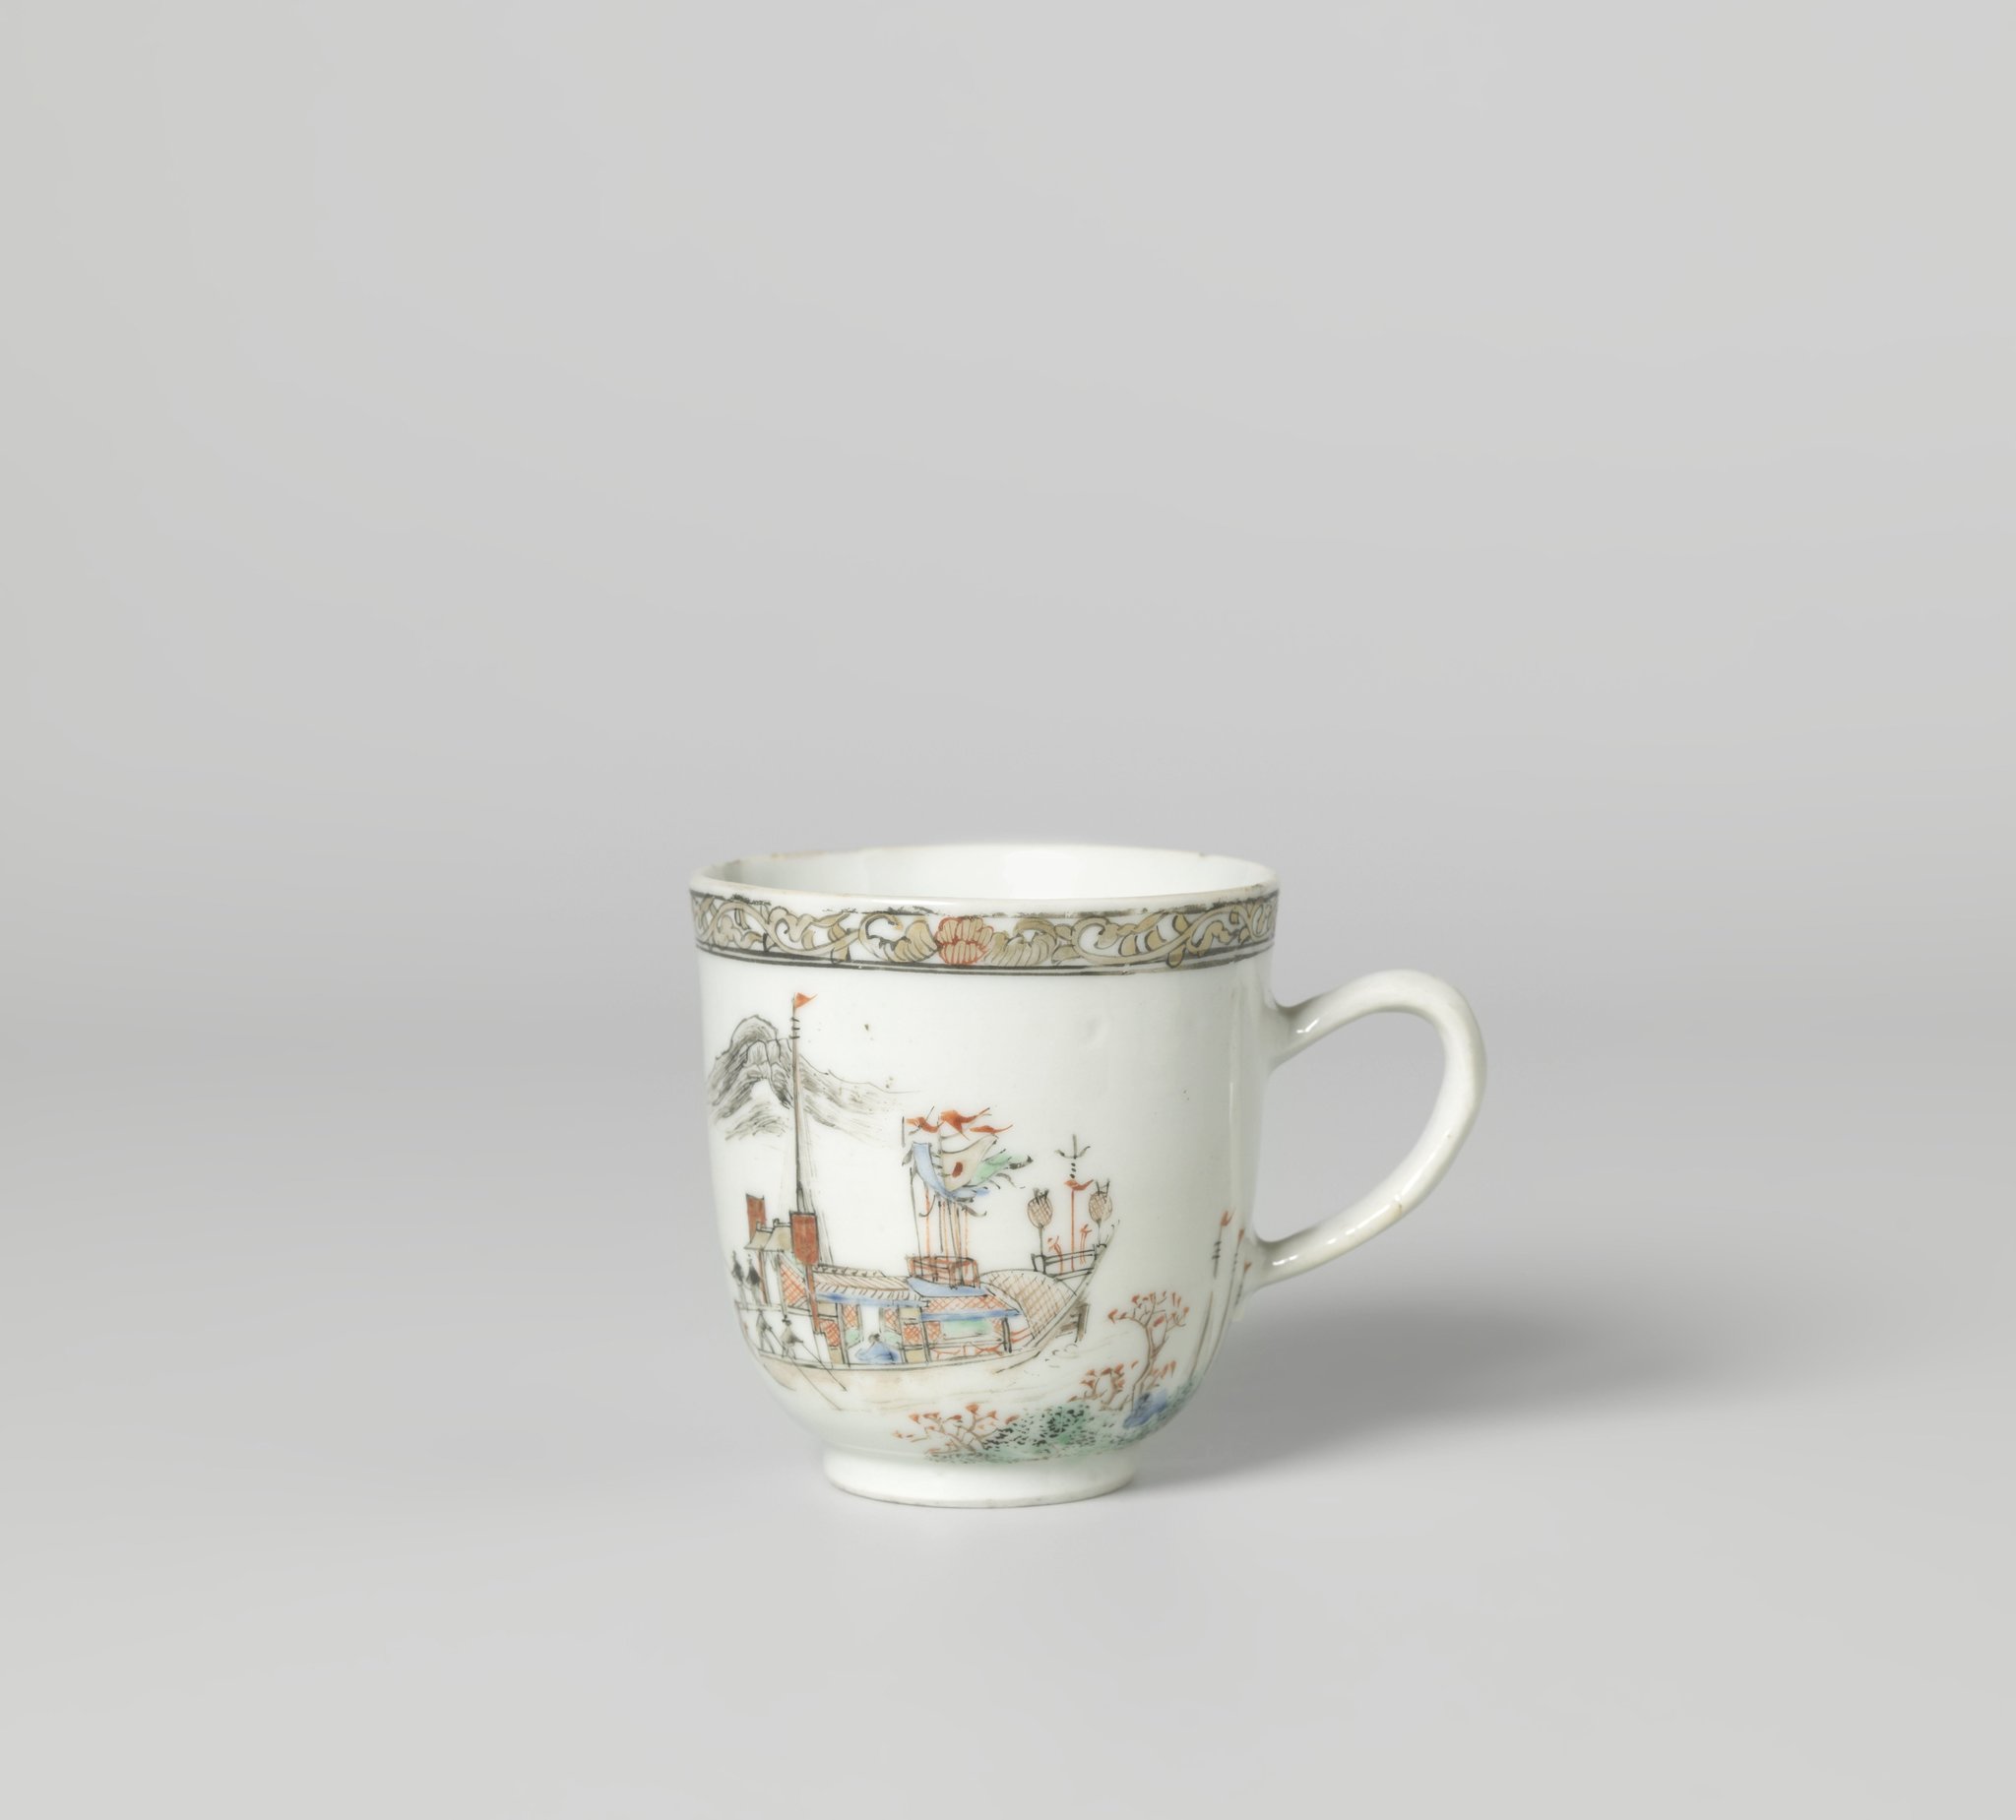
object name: cup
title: Cup with handle with a river landscape with ships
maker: Anonymous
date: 1730-1740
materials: glaze, gold, paint, porcelain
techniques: firing, gilding, turning, vitrification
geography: china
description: Chocoladekop van porselein met c-vormig oor, beschilderd op het glazuur in blauw, rood, groen, zwart en goud. Een rivierlandschap met bergen, bomen en gebouwen, op het water één grote en verschillende kleinere schepen afgebeeld; op de rand een band met bloem- en bladranken. Encre de Chine met emailkleuren.